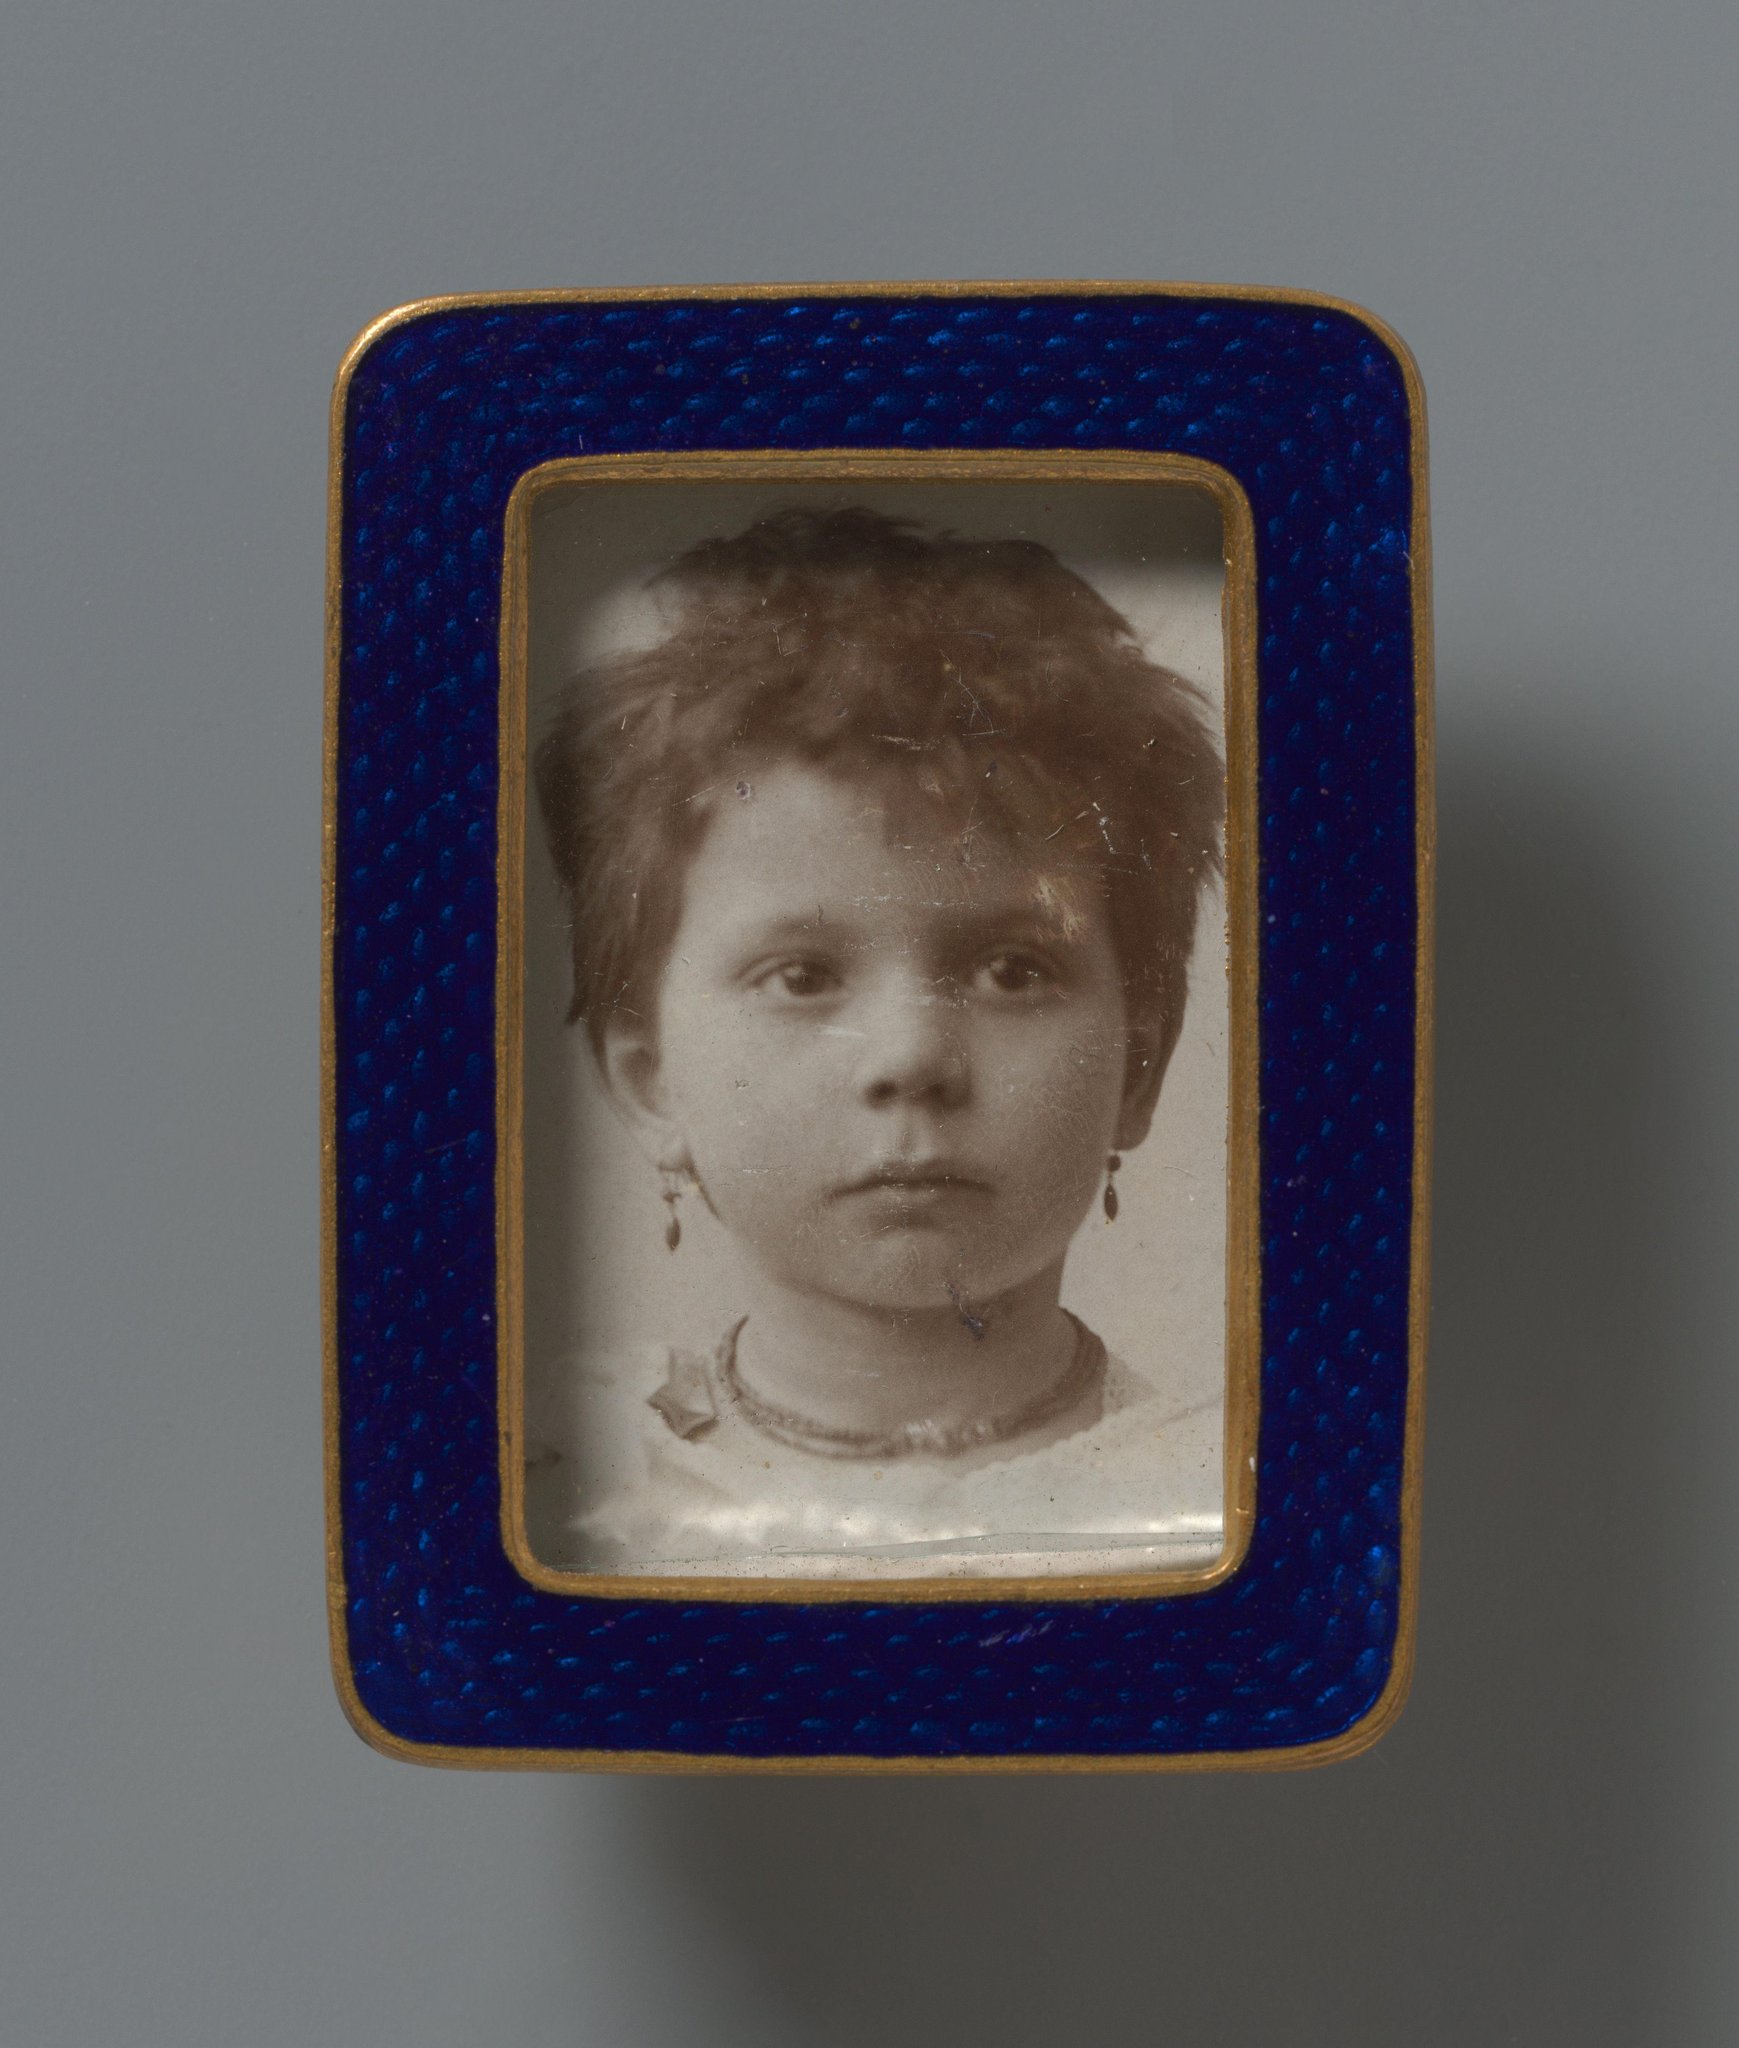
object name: frame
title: Portret van een onbekend kind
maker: Anonymous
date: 1880-1910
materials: paper, glass, metal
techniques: collodion silver print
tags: child, anonymous historical person portrayed